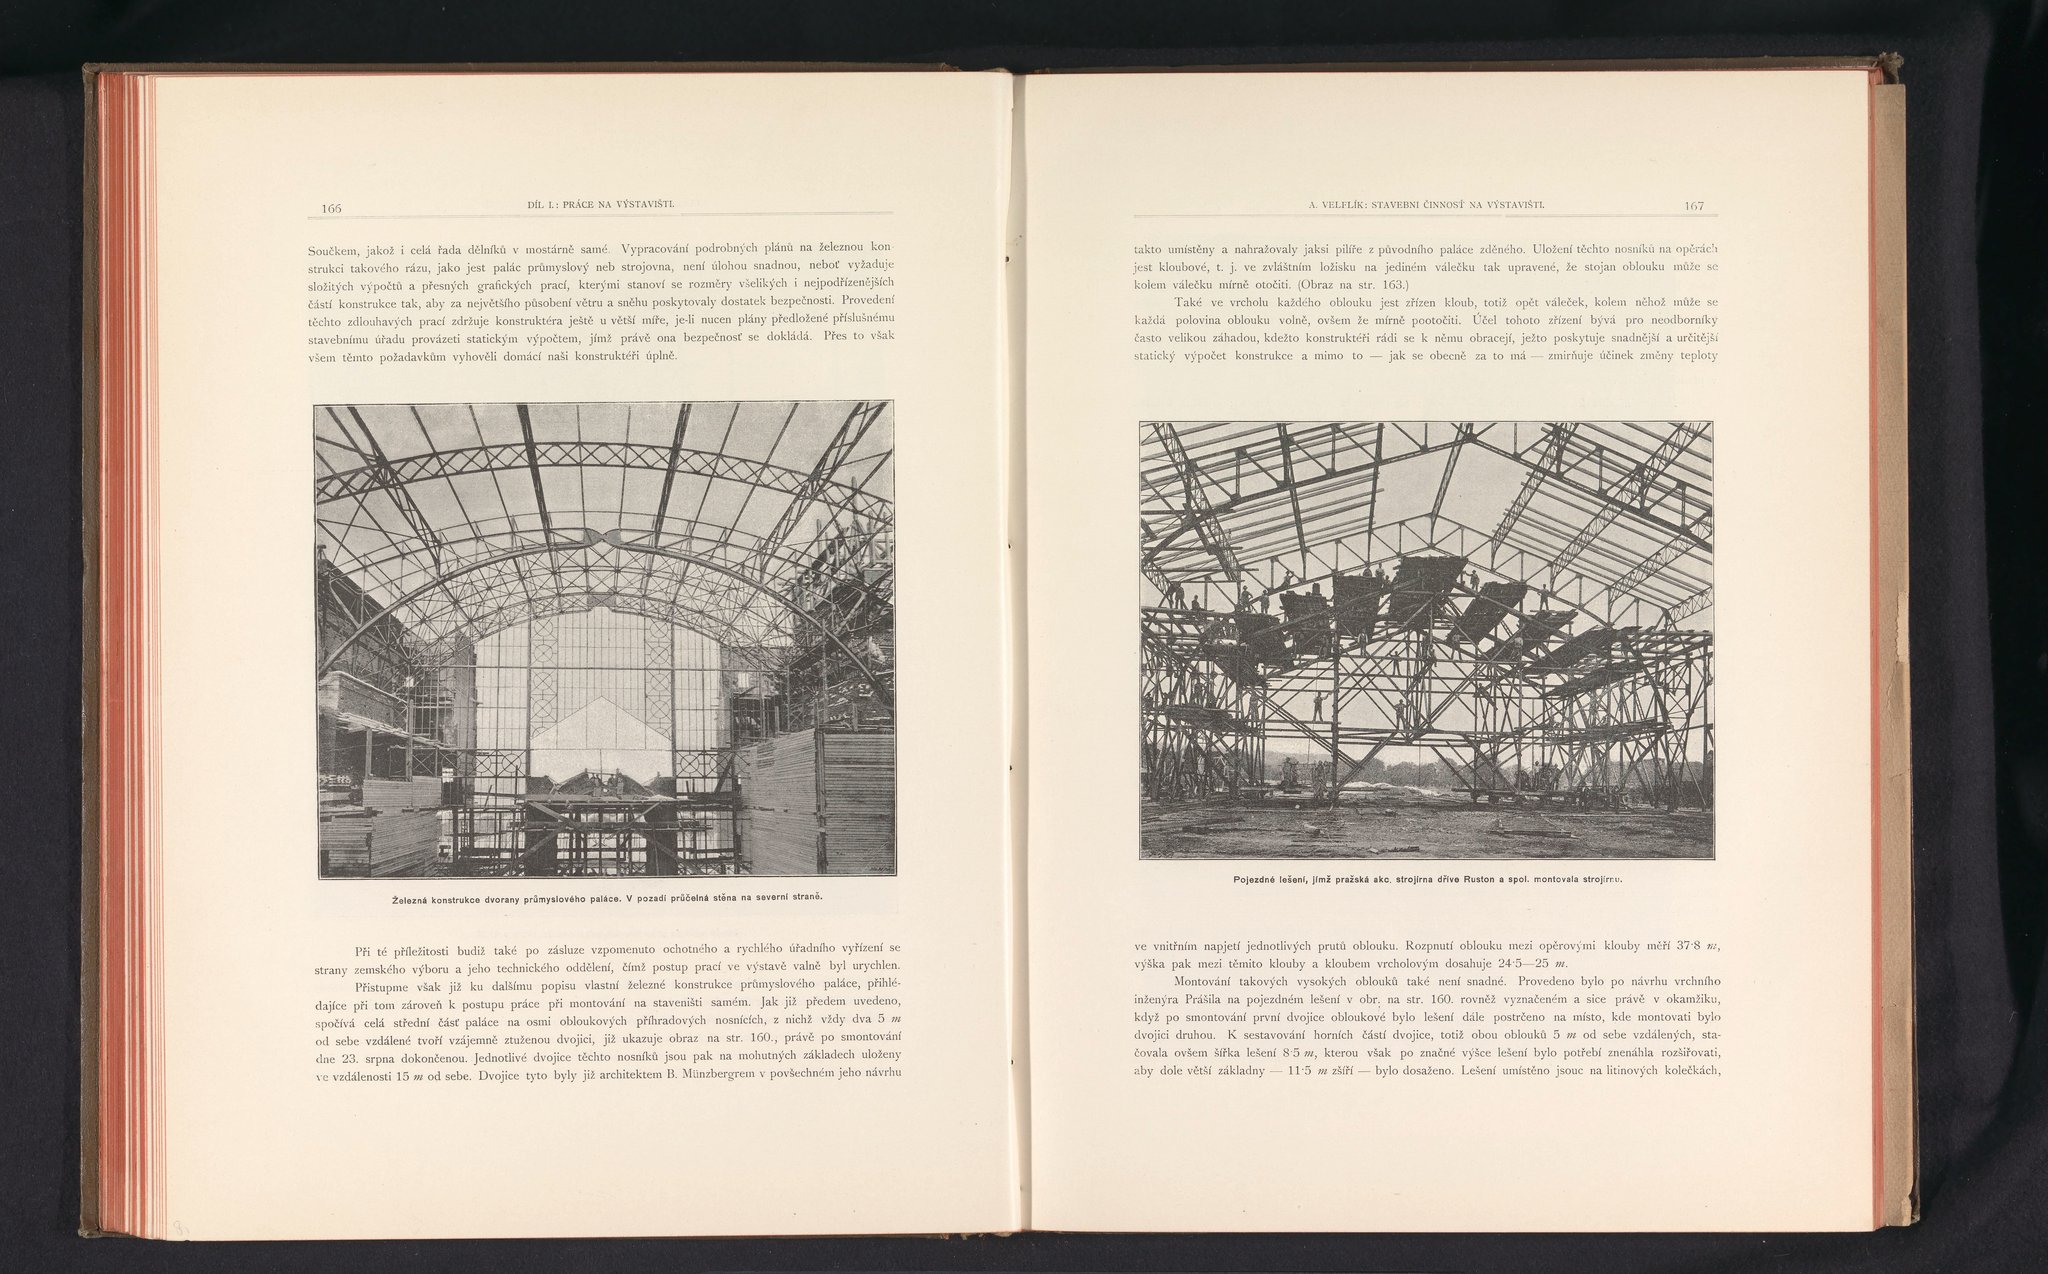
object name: photomechanical print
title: Interieur van het Industriepaleis in aanbouw te Praag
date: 1888-1893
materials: paper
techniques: autotype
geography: prague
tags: building-site